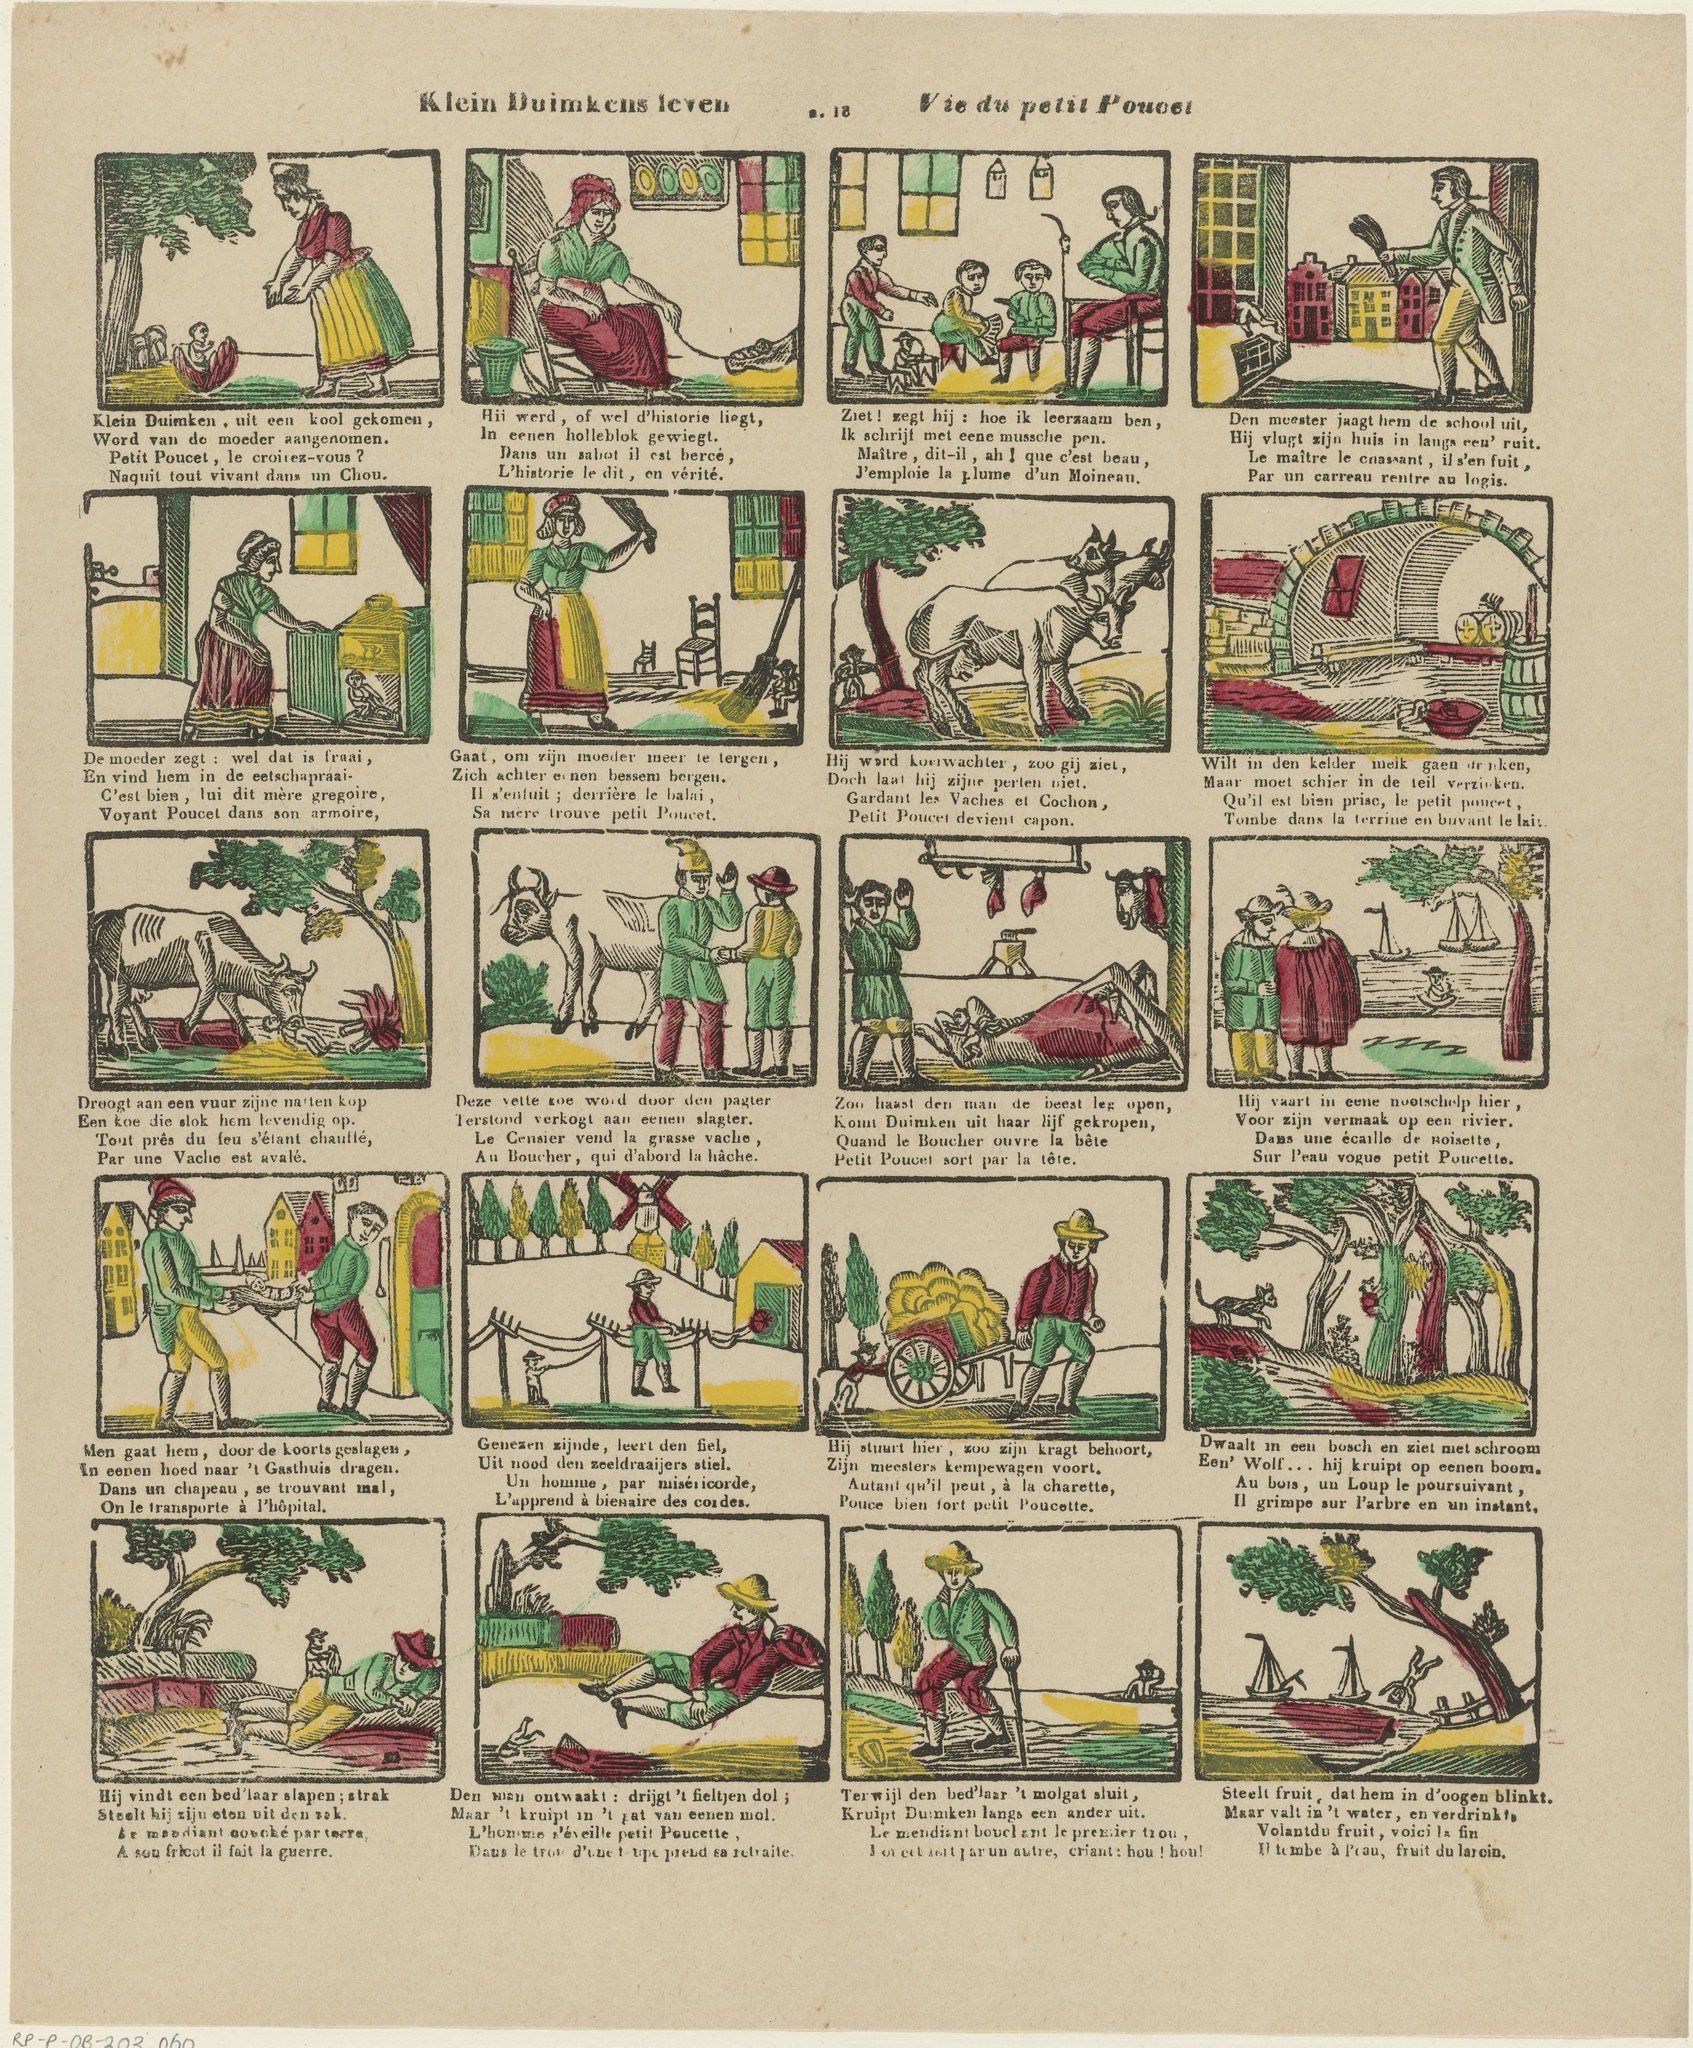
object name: popular print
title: Klein Duimkens leven / Vie du petit Poucet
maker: Anonymous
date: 1856-1900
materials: paper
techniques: colour, letterpress printing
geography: turnhout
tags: tales and fairy tales: little thumbling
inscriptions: collector's mark: Lugt 2760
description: Blad met 20 voorstellingen uit het sprookje van Klein Duimpje. Onder elke afbeelding een tweeregelig vers in het Nederlands en in het Frans. Genummerd midden boven: n. 18.